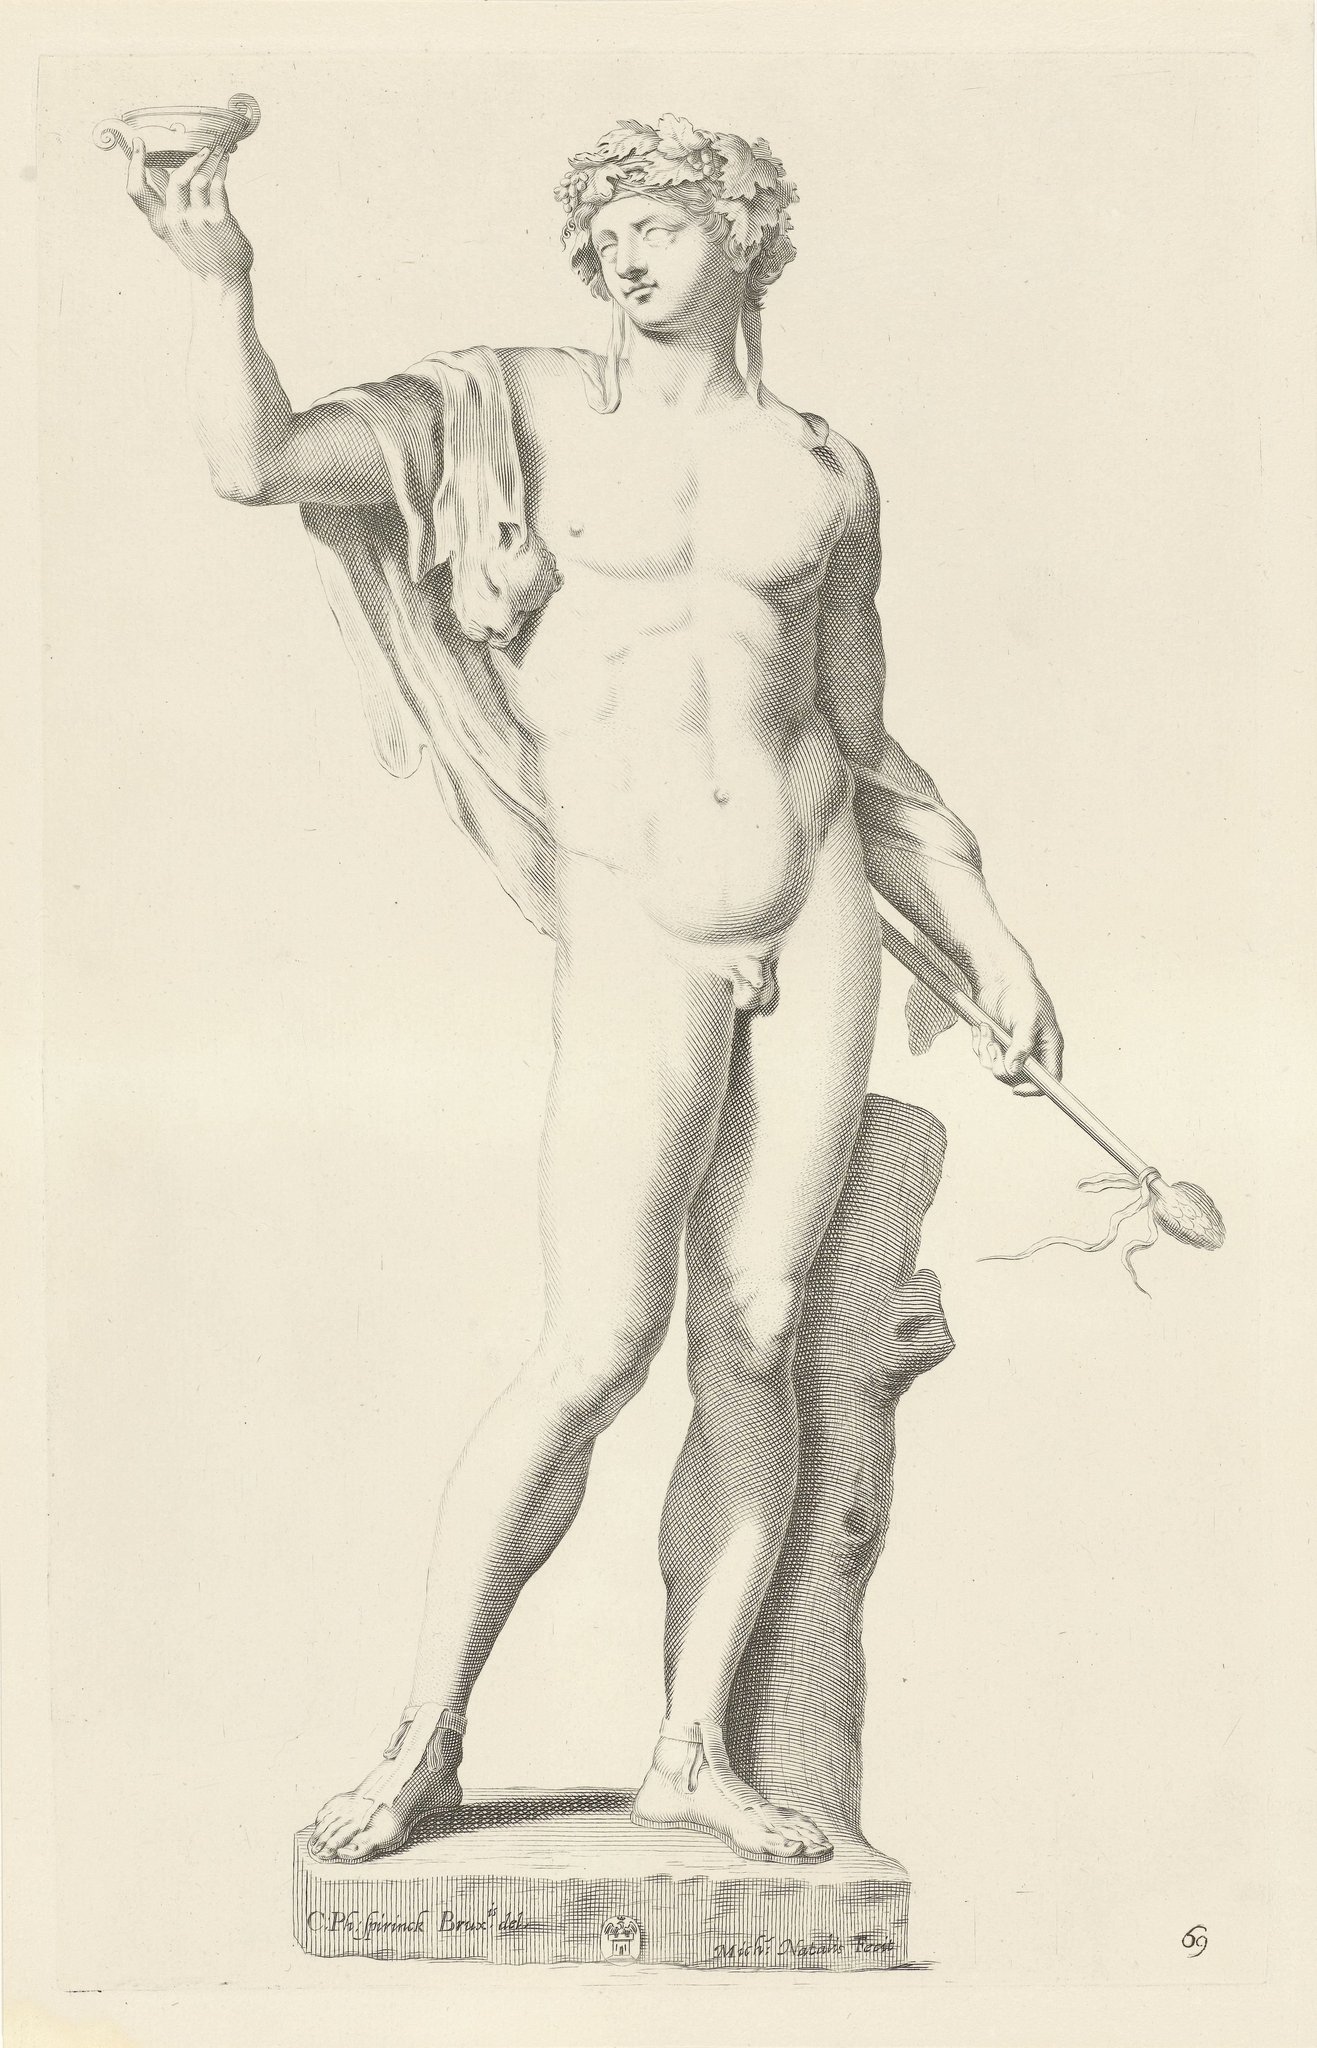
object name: print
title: Galleria Giustiniana del Marchese Vincenzo Giustiniani I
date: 1640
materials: paper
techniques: engraving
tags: rome, vincenzo giustiniani (1564-1637), attributes of bacchus (with name), thyrsus ~ attribute of bacchus, (story of) bacchus (dionysus), liber, piece of sculpture, reproduction of a piece of sculpture, monument, statue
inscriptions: collector's mark: Lugt 2228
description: Standbeeld van Bacchus met in zijn ene hand een geheven drinkkom, in zijn andere hand de Thyrsus. In zijn haren draagt hij wingerdbladeren en druiven, over zijn schouder hangt de huid van een panter. Hij staat naast een boomstam. Midden onder op de basis het wapenschild van Vincenzo Giustiniani. Prent uit een serie naar de sculpturen in de verzameling in de Galleria Giustiniani te Rome.